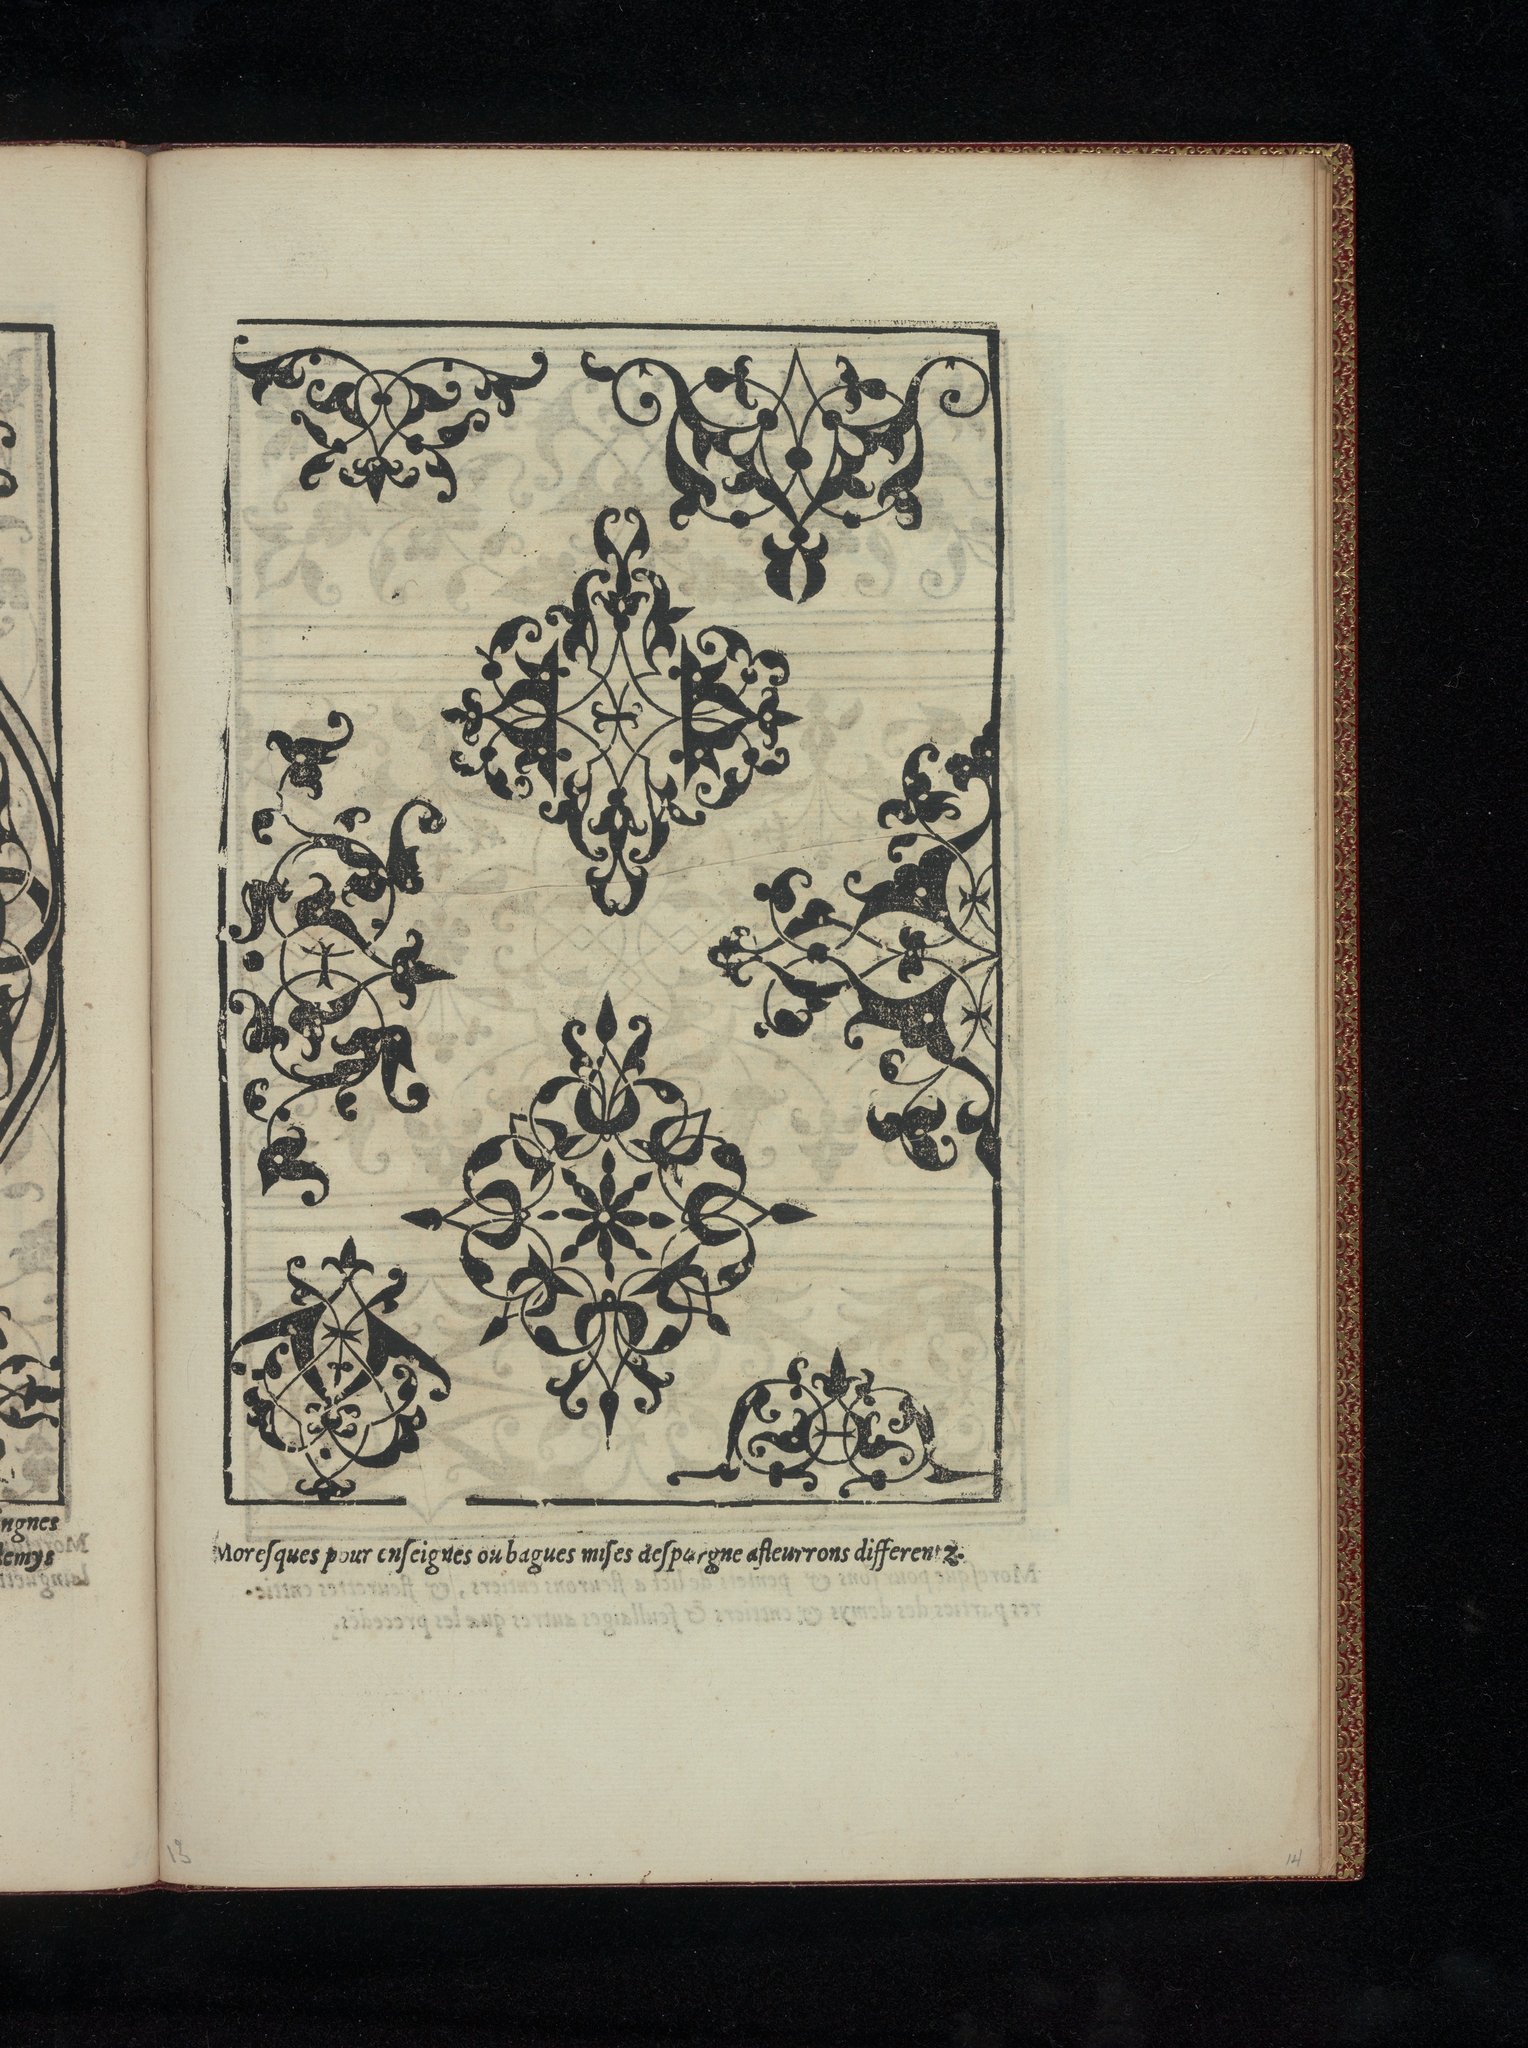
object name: book print ornament architecture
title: Livre de Moresques, page 14 (recto)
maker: francesco di pellegrino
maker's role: artist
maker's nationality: italian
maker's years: 1525-1552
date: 1546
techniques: woodcut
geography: france